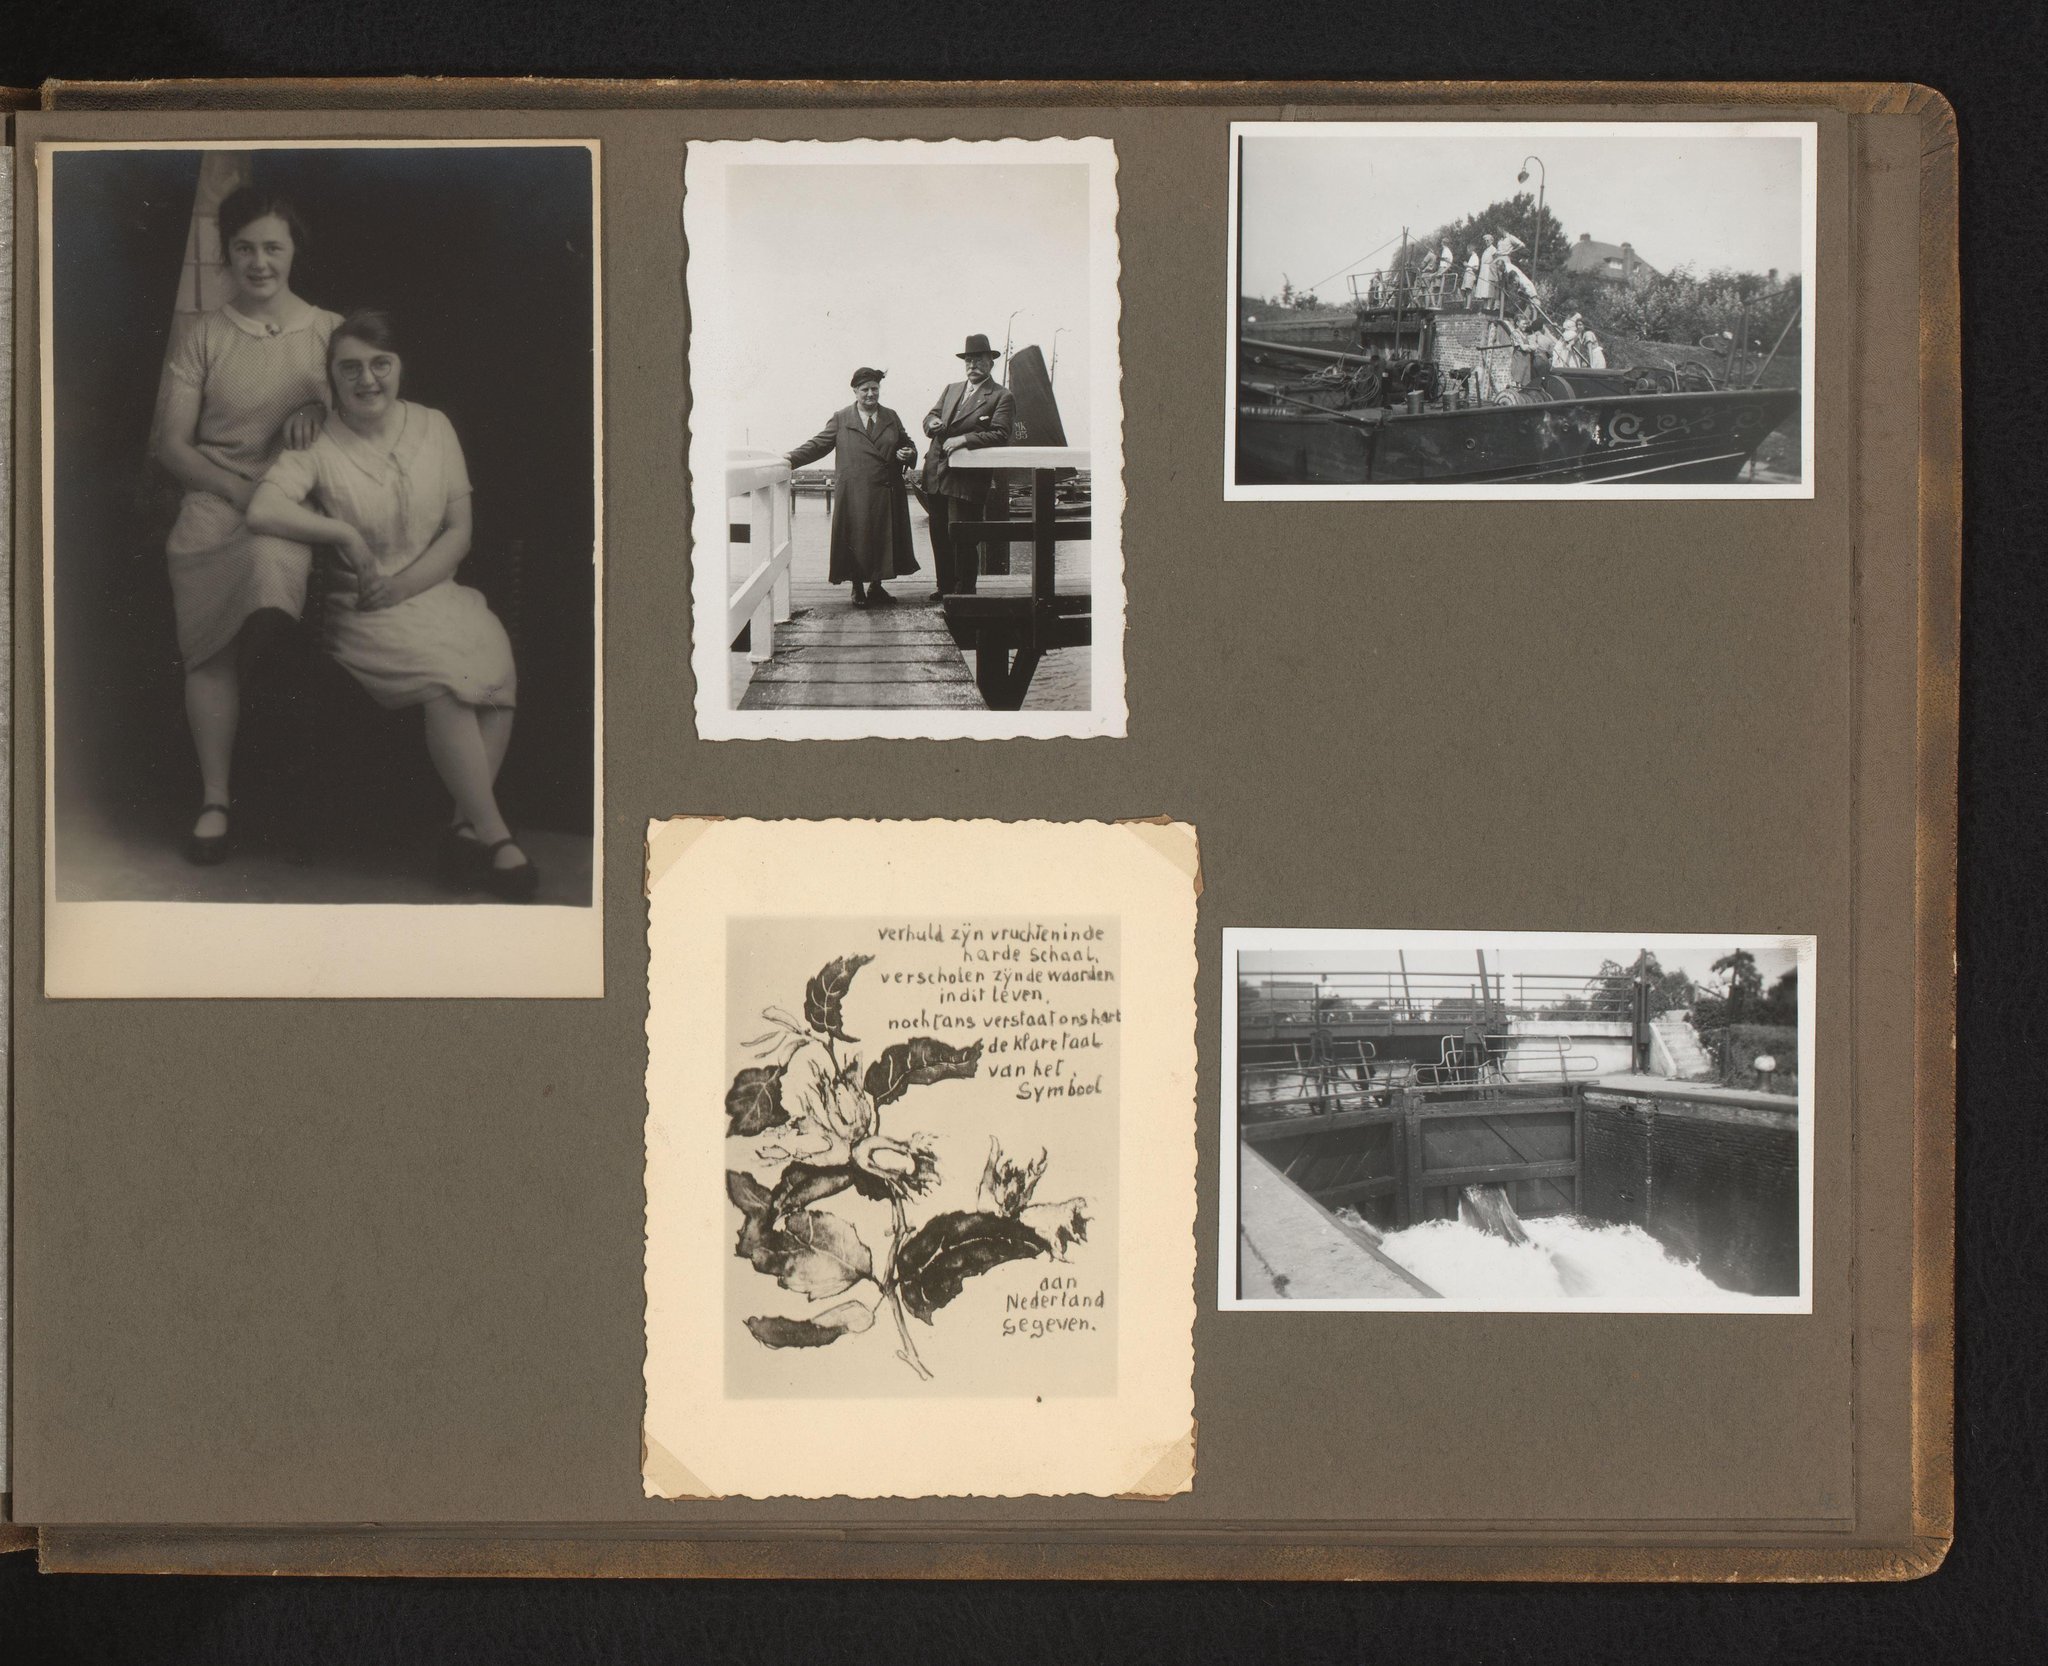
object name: reproduction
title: Diverse afbeeldingen waaronder een mogelijke reproductie van een brandplaatje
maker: Anonymous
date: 1900-1950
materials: photographic support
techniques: gelatin silver print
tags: print maker, wilhelmina of the netherlands, utrecht, bernhard (prins der nederlanden), beatrix (koningin der nederlanden), juliana of the netherlands, adult woman, adult man, historical persons, ships (in general), lift-lock, canal lock, pamphlet ~ printed matter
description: Twee portretten en een gezicht op een boot en een sluis. De pagina bevat ook een mogelijke reproductie van een pamflet dat tijdens de Tweede Wereldoorlog verspreid werd. Hierop afgebeeld is een hazelaartak met in de bladeren de profielen van het koningshuis; prins Bernhard, koningin Wilhelmina, koningin Juliana, koningin Beatrix en prinsen Irene. Deze pagina maakt deel uit van een album.